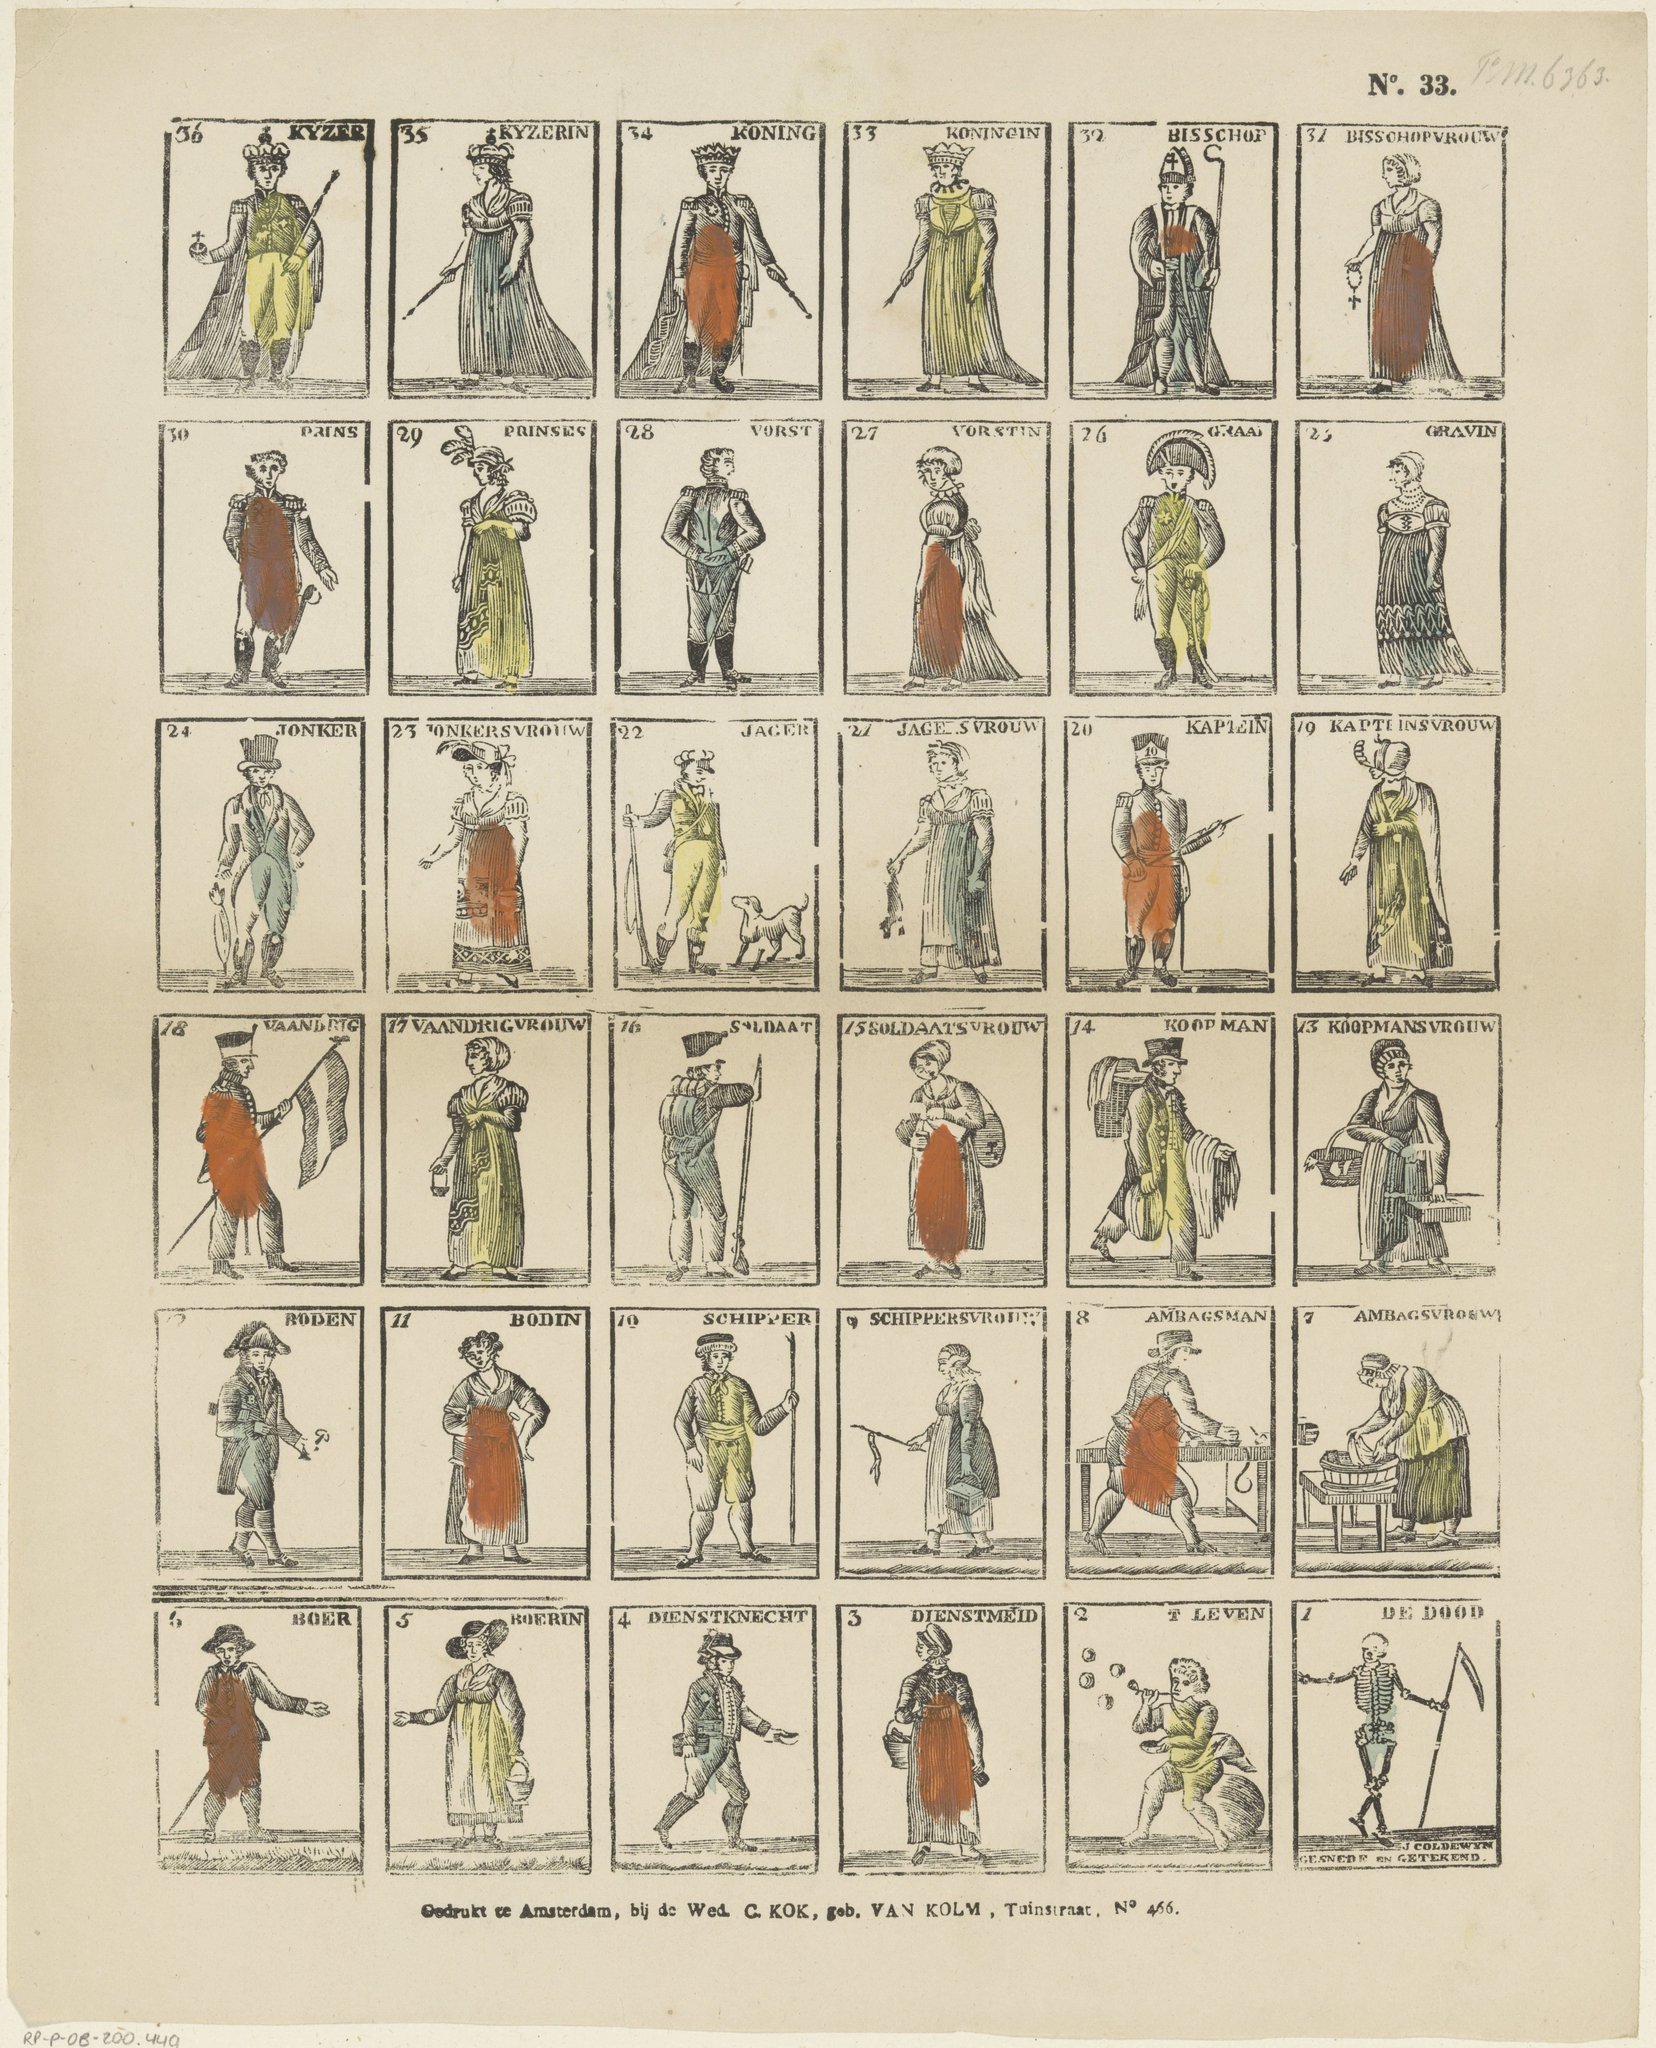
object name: print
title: Floskaartjes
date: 1842-1866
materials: paper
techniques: colour, letterpress printing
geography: amsterdam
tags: symbols and personifications of death, social position, playing-cards, nobility and patriciate; chivalry, knighthood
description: Blad met 36 speelkaarten (floskaartjes) met voorstellingen van verschillende figuren. De afbeeldingen vormen achttien paren, aflopend genummerd van bovenaan links nummer 36 tot onderaan rechts nummer 1. Op de twee laagste nummers na tonen ze zeventien koppels, man en vrouw, met de man net één nummer hoger dan de vrouw, waarbij elk paar een beroep of een maatschappelijke positie voorstelt. Genummerd rechtsboven: No. 33.